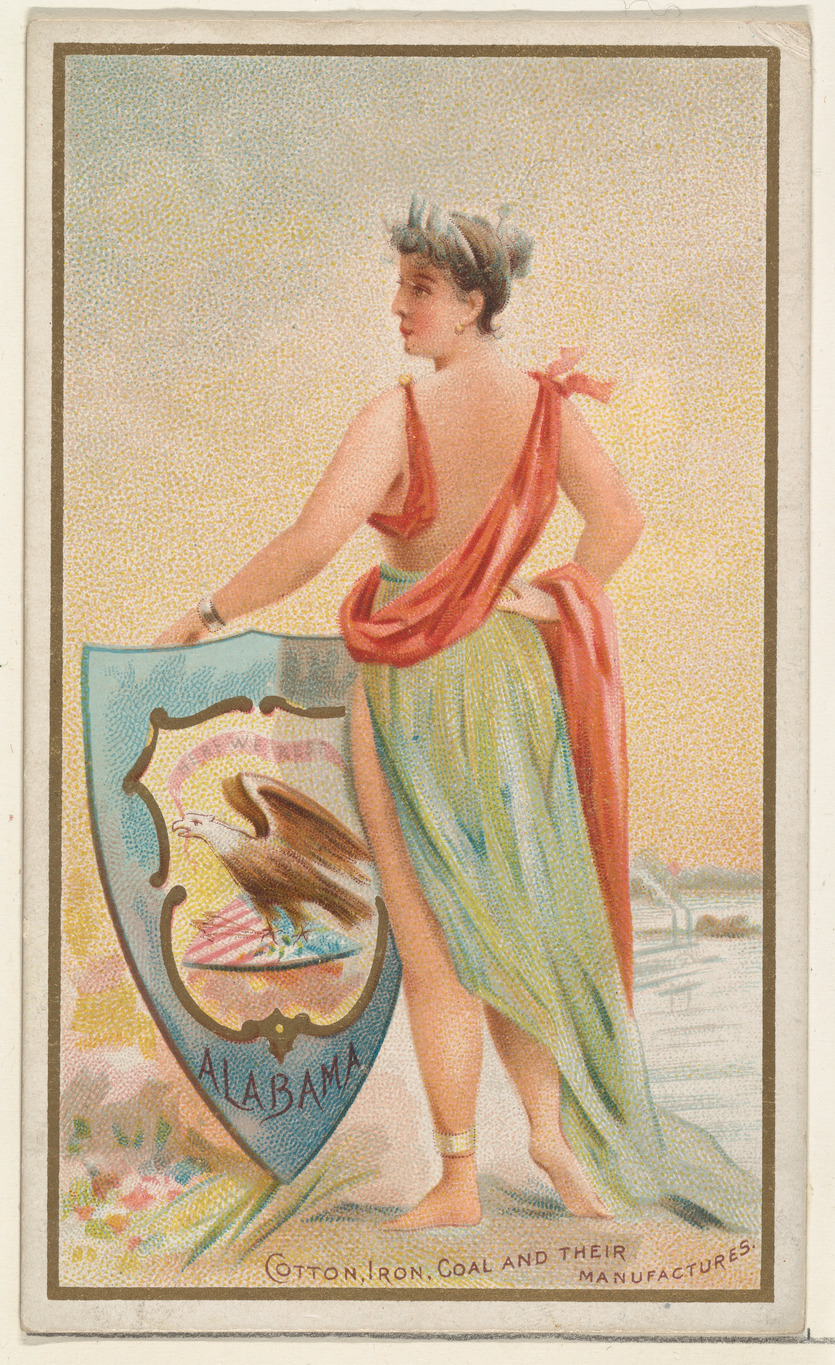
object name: print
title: Alabama, from the Industries of States series (N117) issued by Duke Sons & Co. to promote Honest Long Cut Tobacco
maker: w. duke, sons & co.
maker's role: publisher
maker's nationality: american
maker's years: 1870-1920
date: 1889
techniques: color lithograph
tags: shields,women